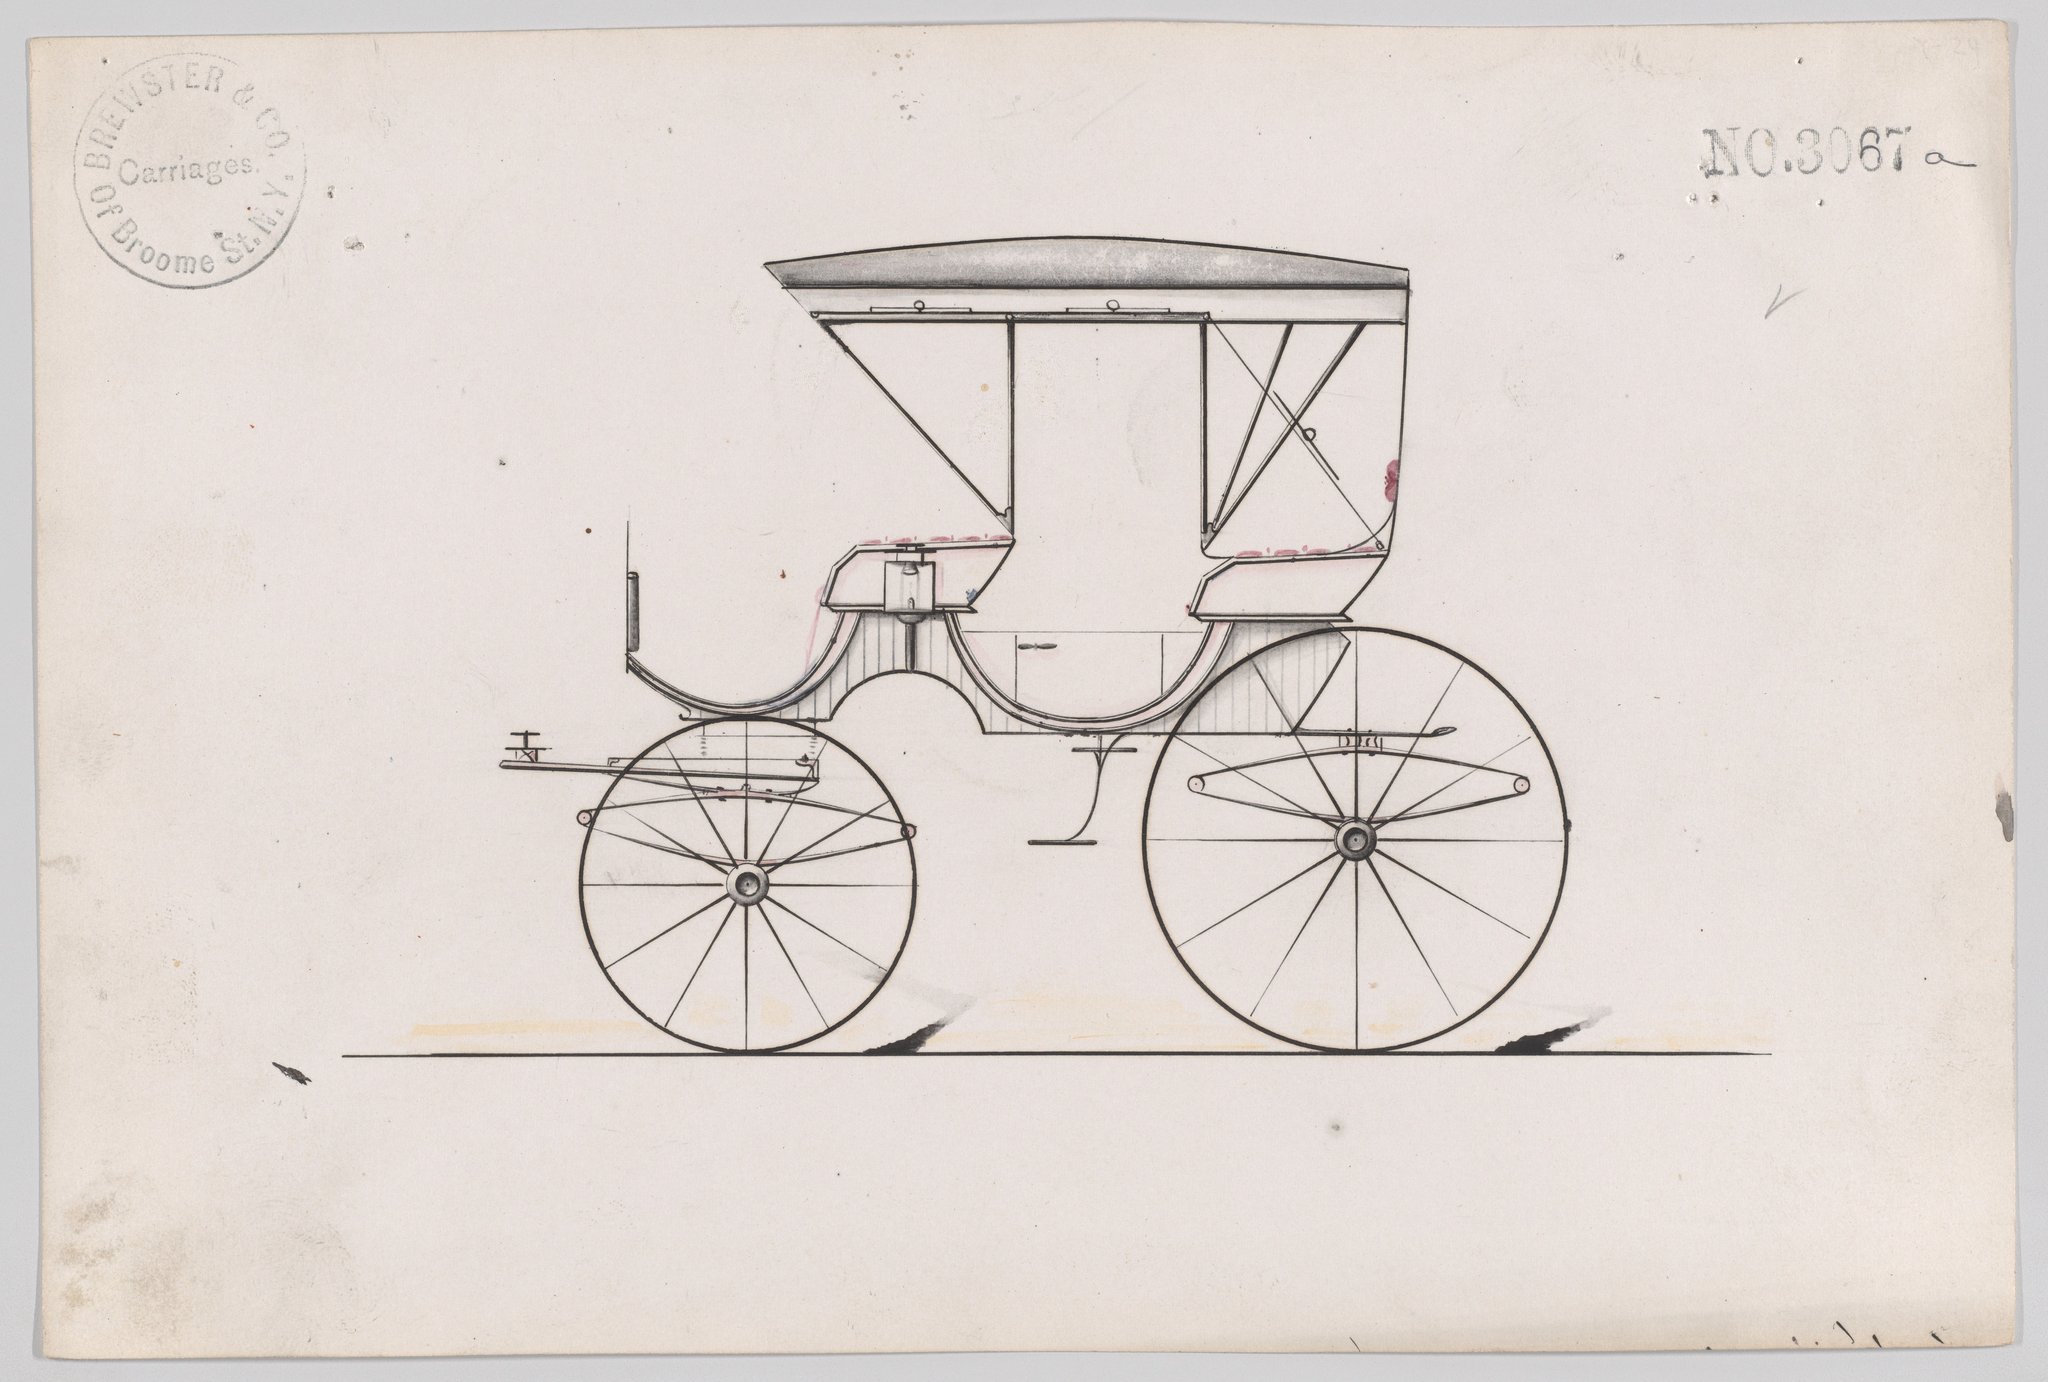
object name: drawing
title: Design for Park Phaeton, no. 3067a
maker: brewster & co.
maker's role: manufacturer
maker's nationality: american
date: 1874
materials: gouache, graphite, ink, watercolor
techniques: pen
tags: carriages